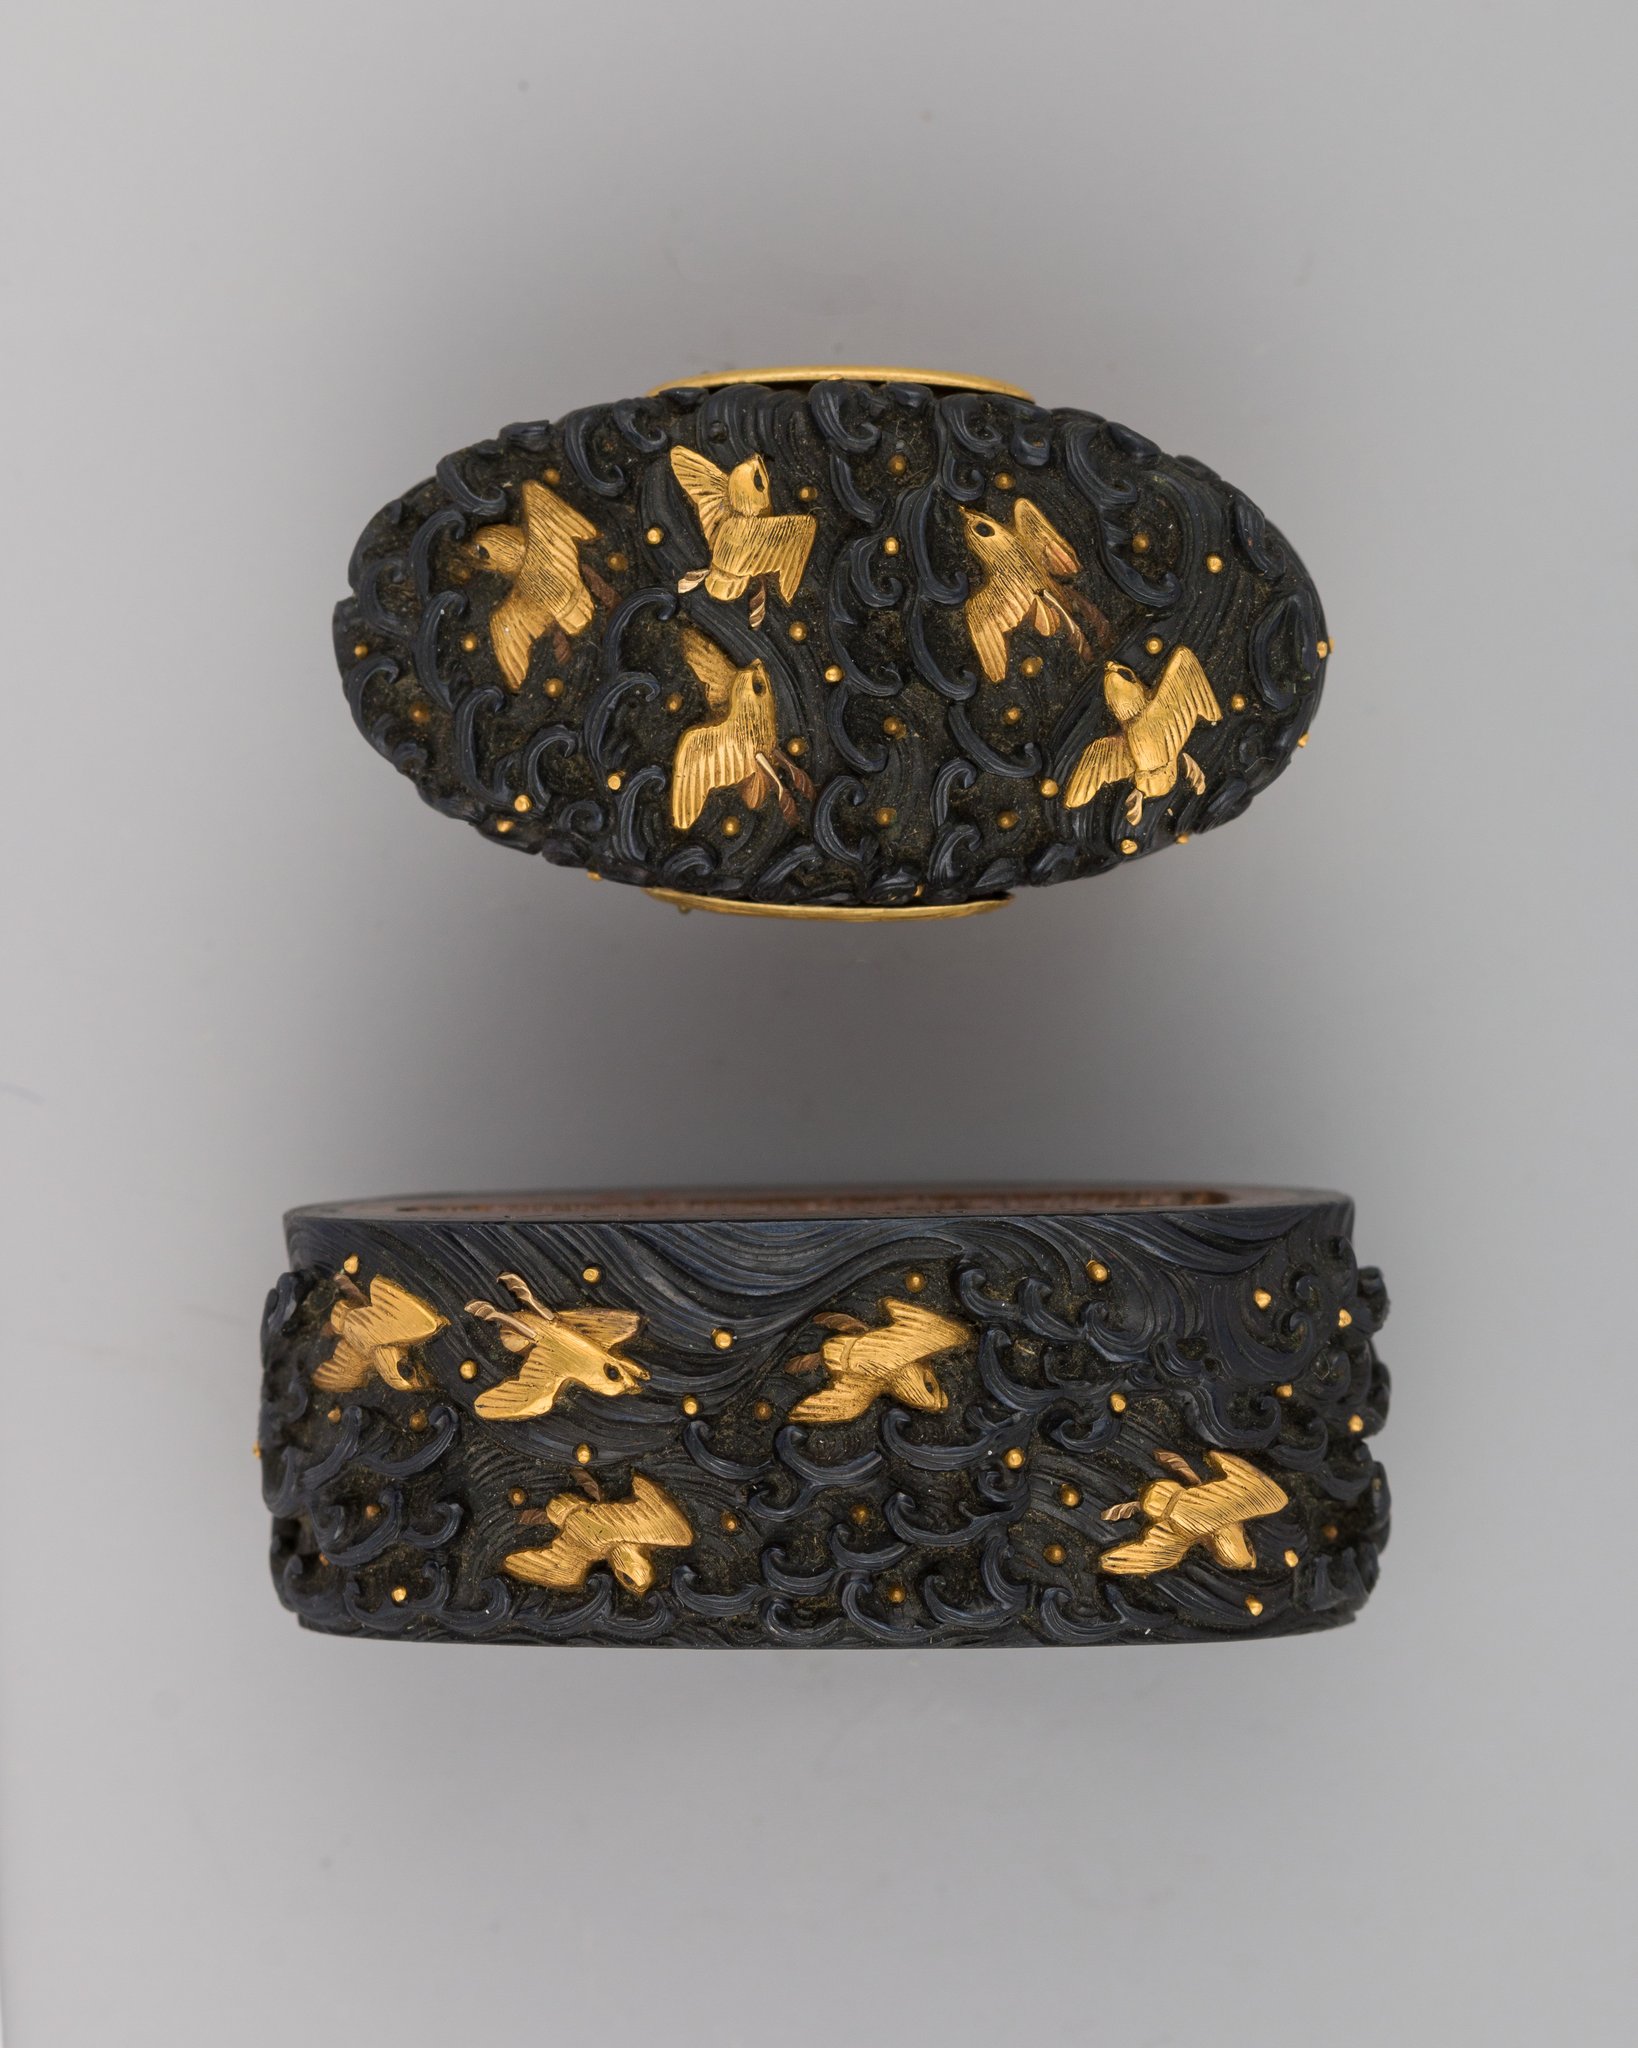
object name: sword hilt collar and pommel fuchigashira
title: Sword-Hilt Collar and Pommel (Fuchigashira)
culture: japanese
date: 1701-1800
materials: gold alloy, gold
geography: japan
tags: birds